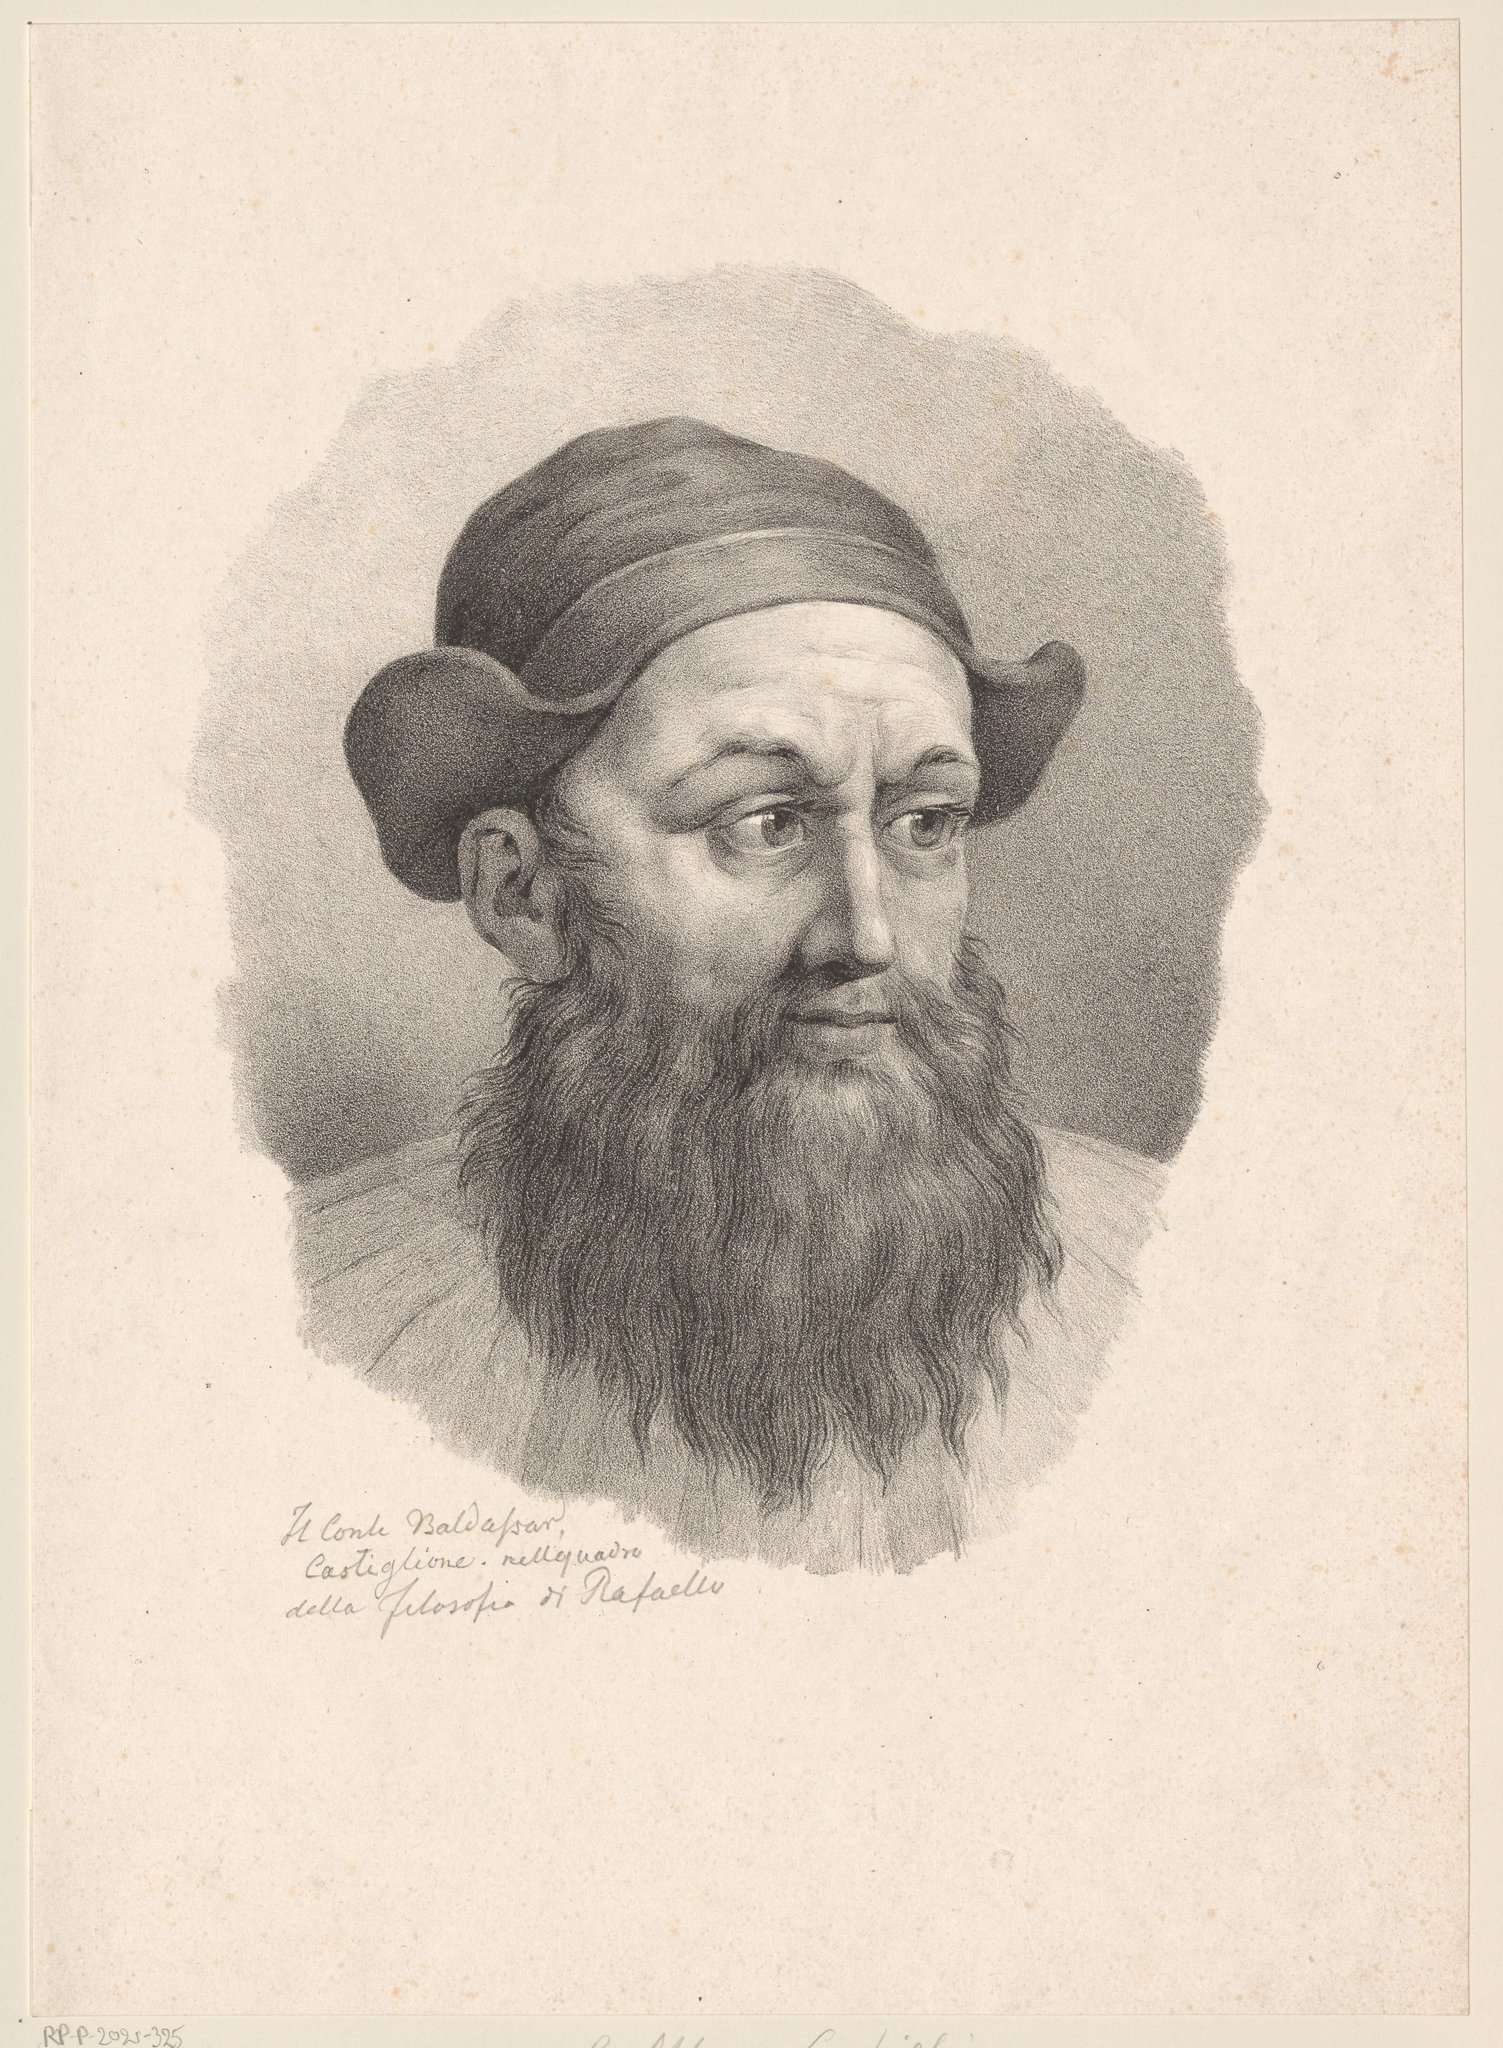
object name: print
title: Portret van Baldassare Castiglione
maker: Anonymous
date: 1795-1899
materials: paper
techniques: lithograph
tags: historical persons